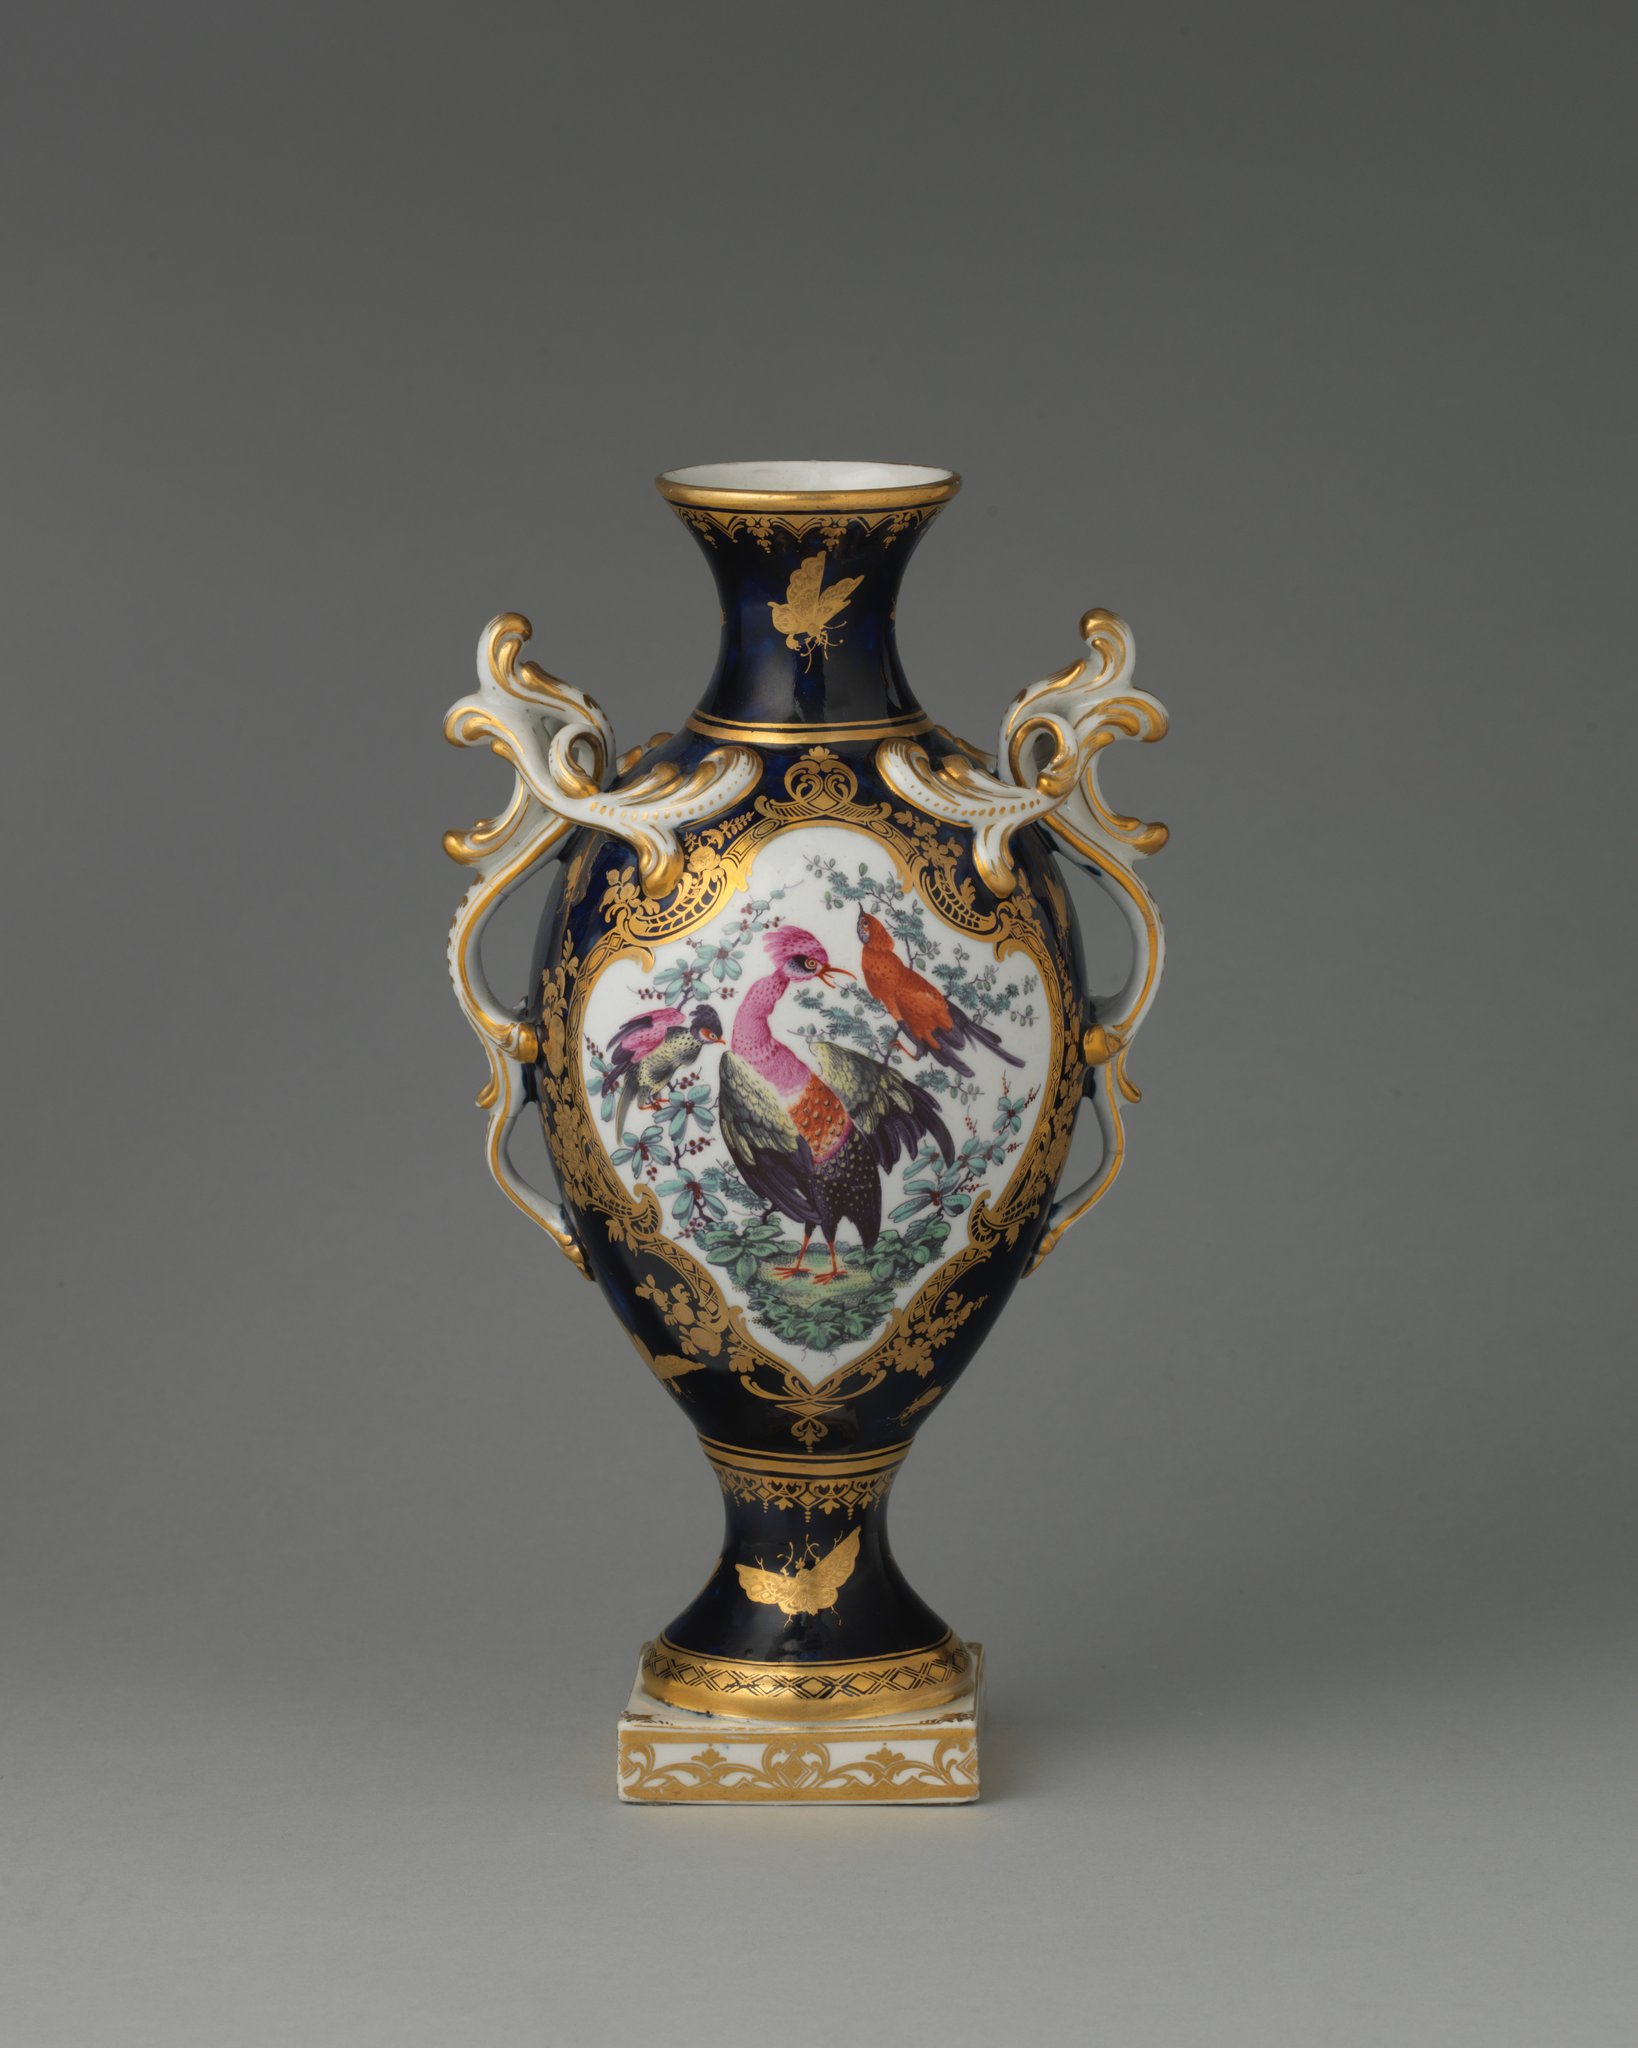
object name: vase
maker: chelsea porcelain manufactory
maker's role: factory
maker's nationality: british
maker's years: 1744-1784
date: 1765-1770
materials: soft paste porcelain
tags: birds,flowers